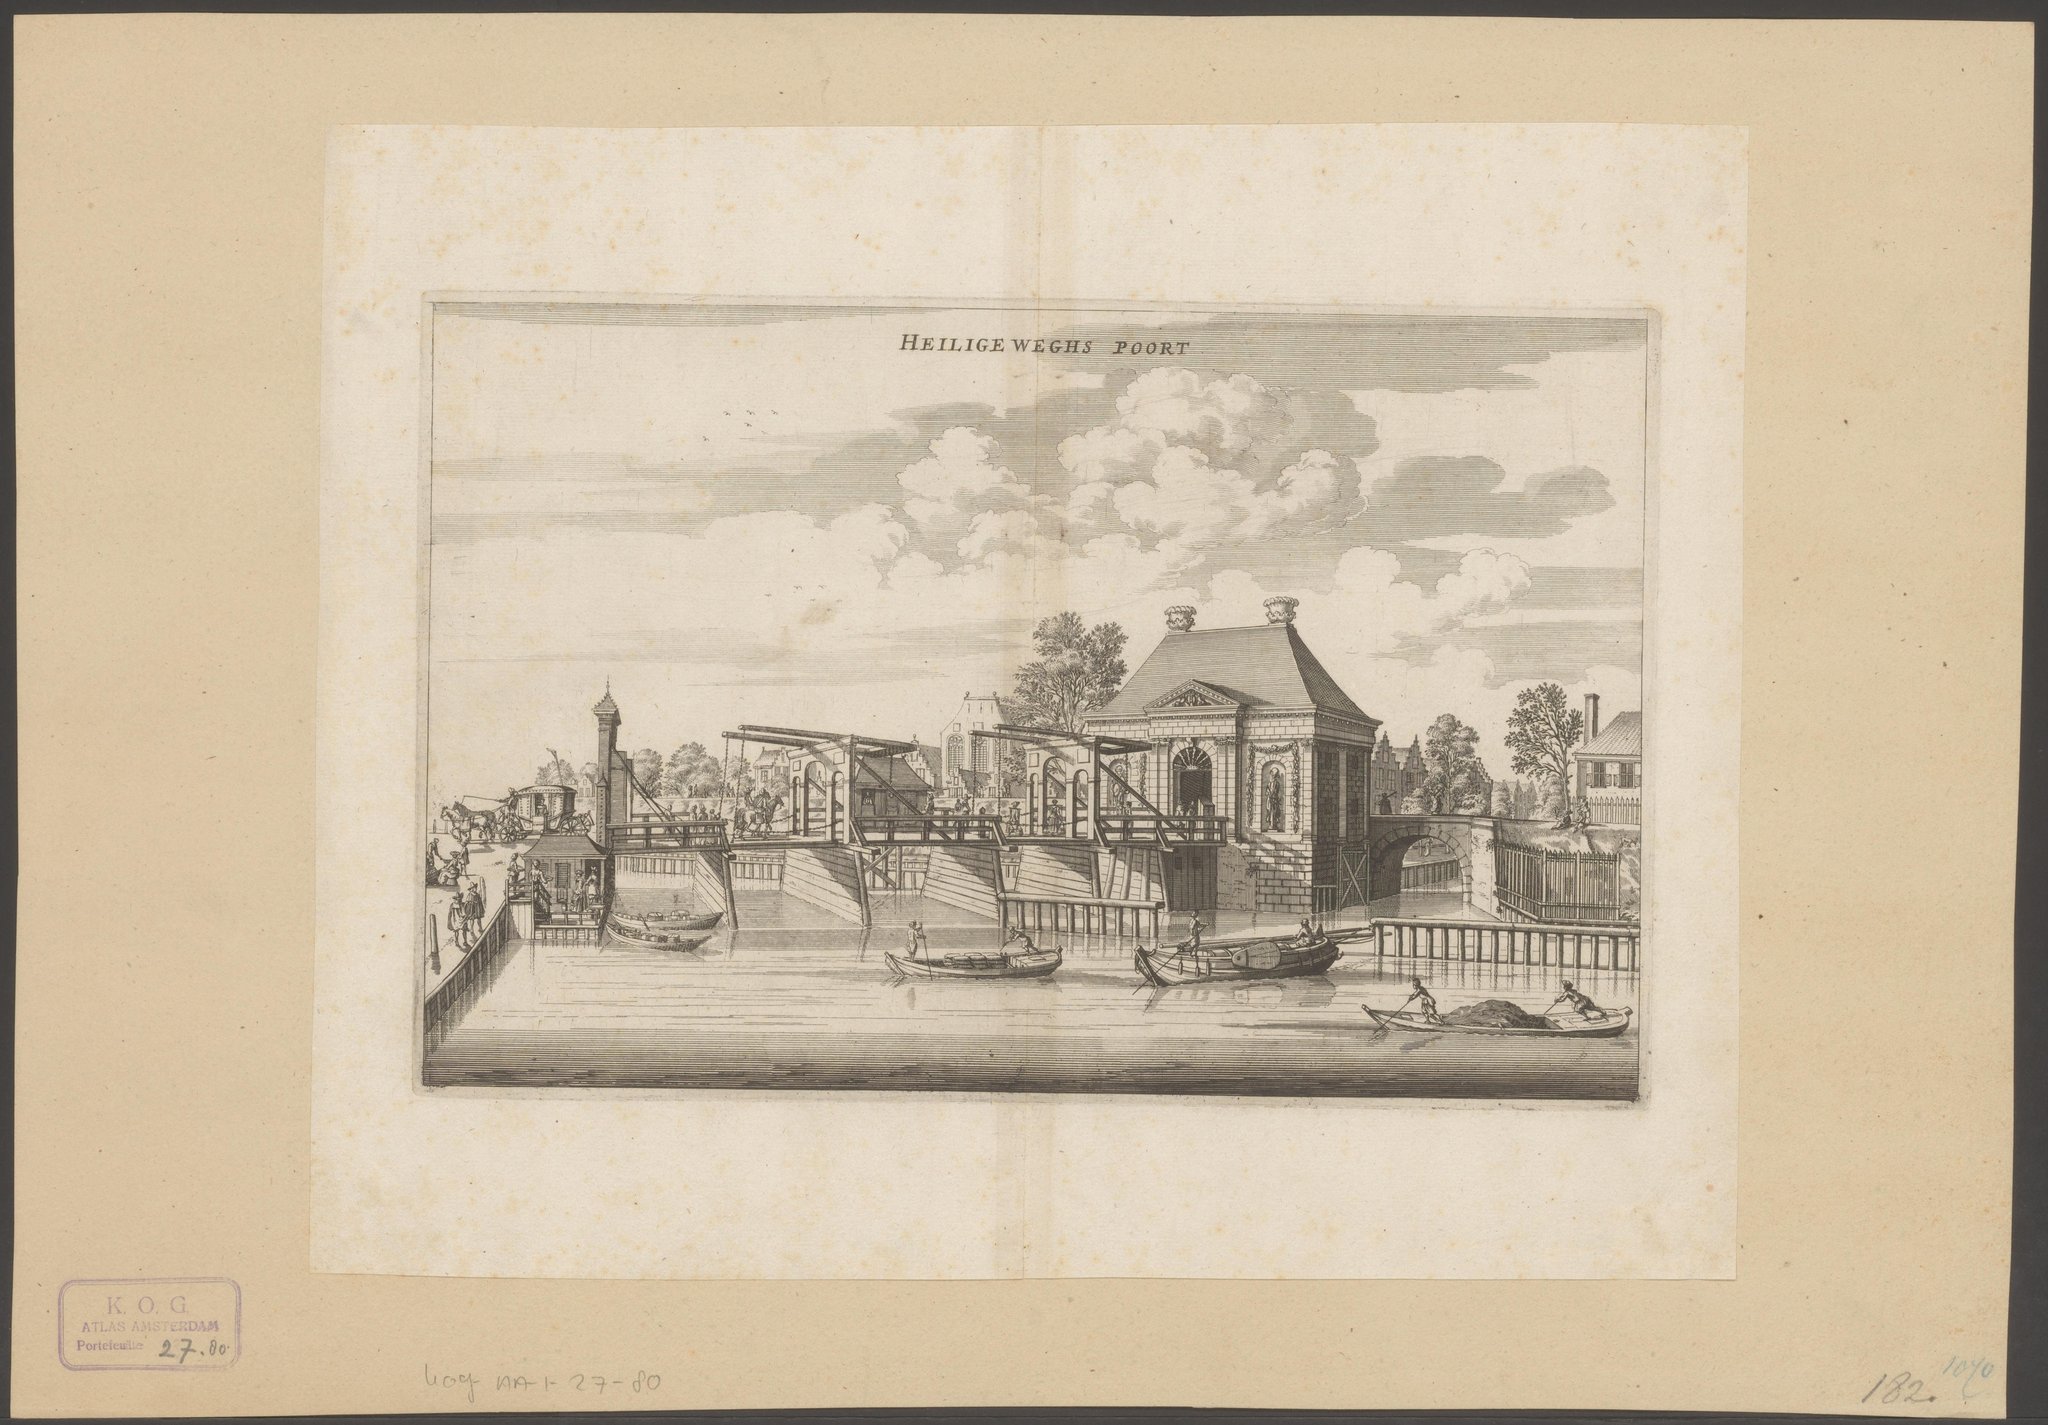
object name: print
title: Gezicht op de Heiligewegspoort van buiten de stad gezien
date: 1663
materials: paper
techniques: engraving, etching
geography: amsterdam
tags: city-gate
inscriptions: collector's mark: Lugt 1641b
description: Prent uit: Dapper, Olfert. Historische beschryving der stadt Amsterdam (...). Amsterdam: Jacob van Meurs, 1663, tussen p. 450-451. Een identieke versie van de prent bestaat met een Frans opschrift boven het Nederlandse opschrift.